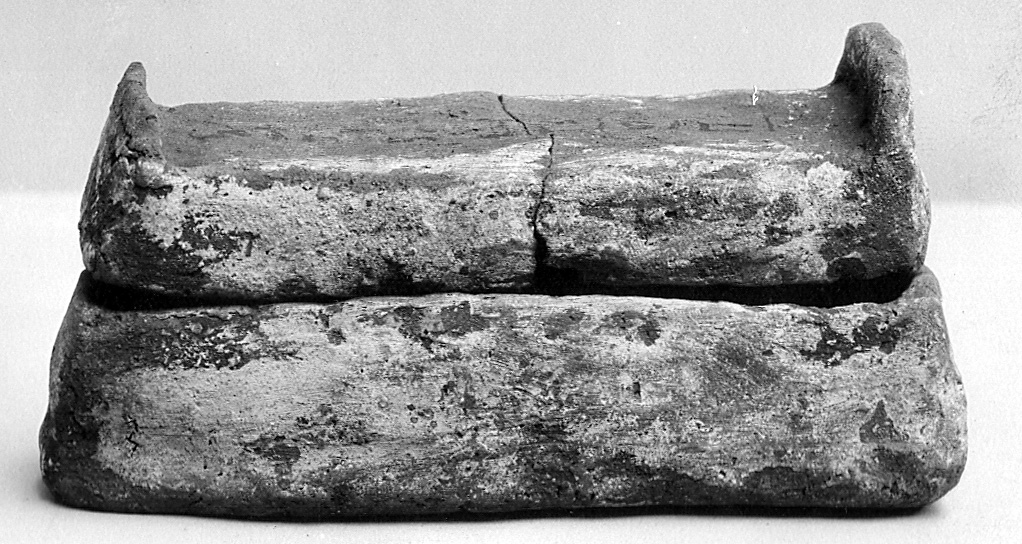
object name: shabti coffin, clay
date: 1635-1458 BCE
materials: clay, paint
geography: egypt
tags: coffins